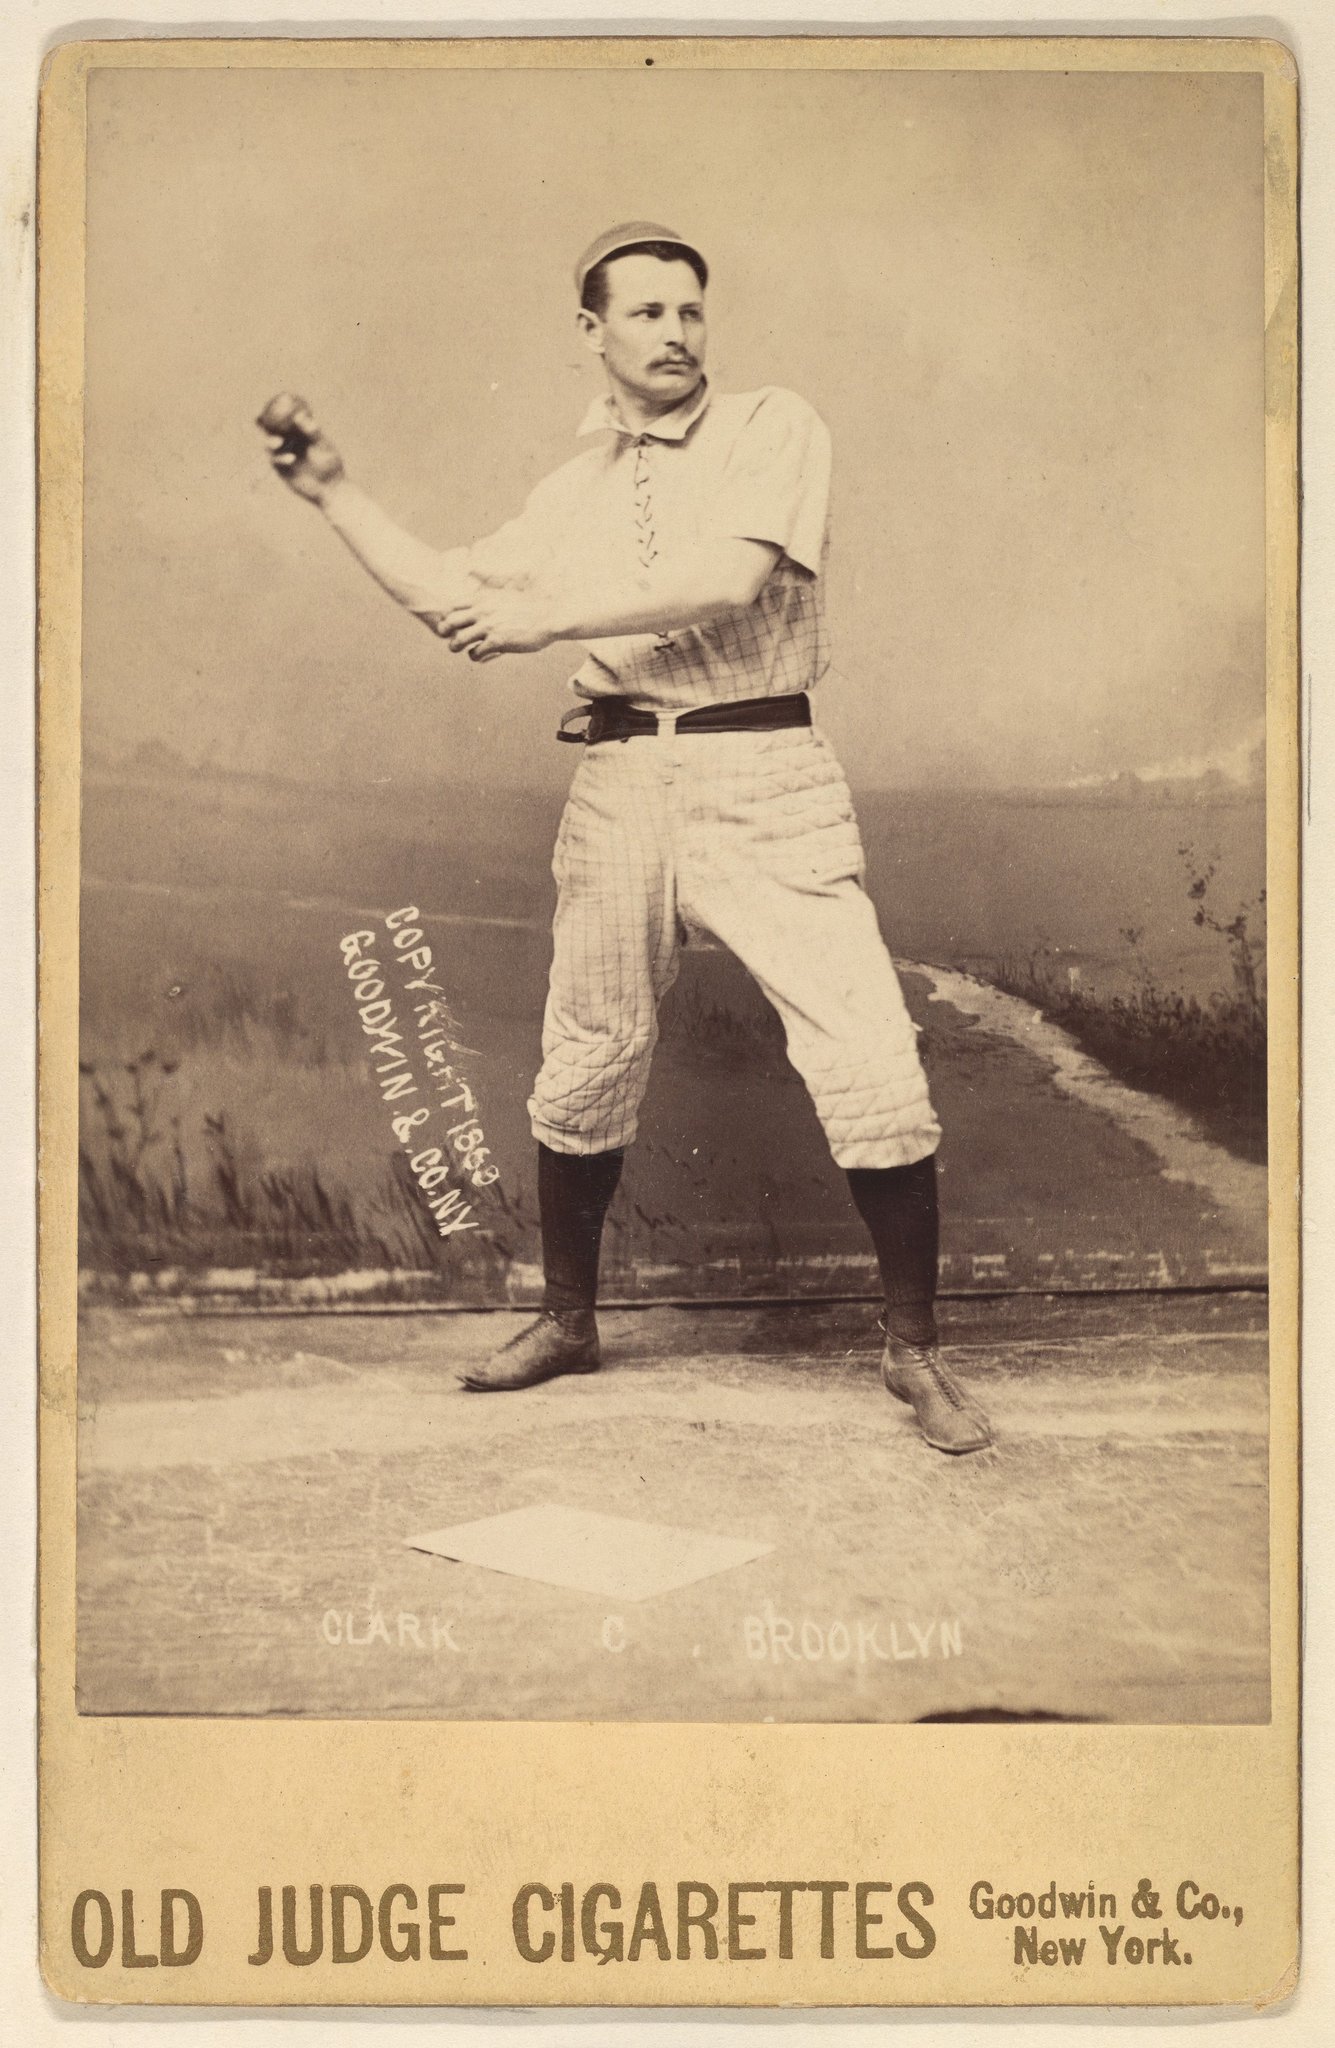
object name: baseball card, photograph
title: Clark, Catcher, Brooklyn, from the series Old Judge Cigarettes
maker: goodwin & company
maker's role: publisher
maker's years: 1850-1950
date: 1888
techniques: albumen silver print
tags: men,portraits,baseball,athletes